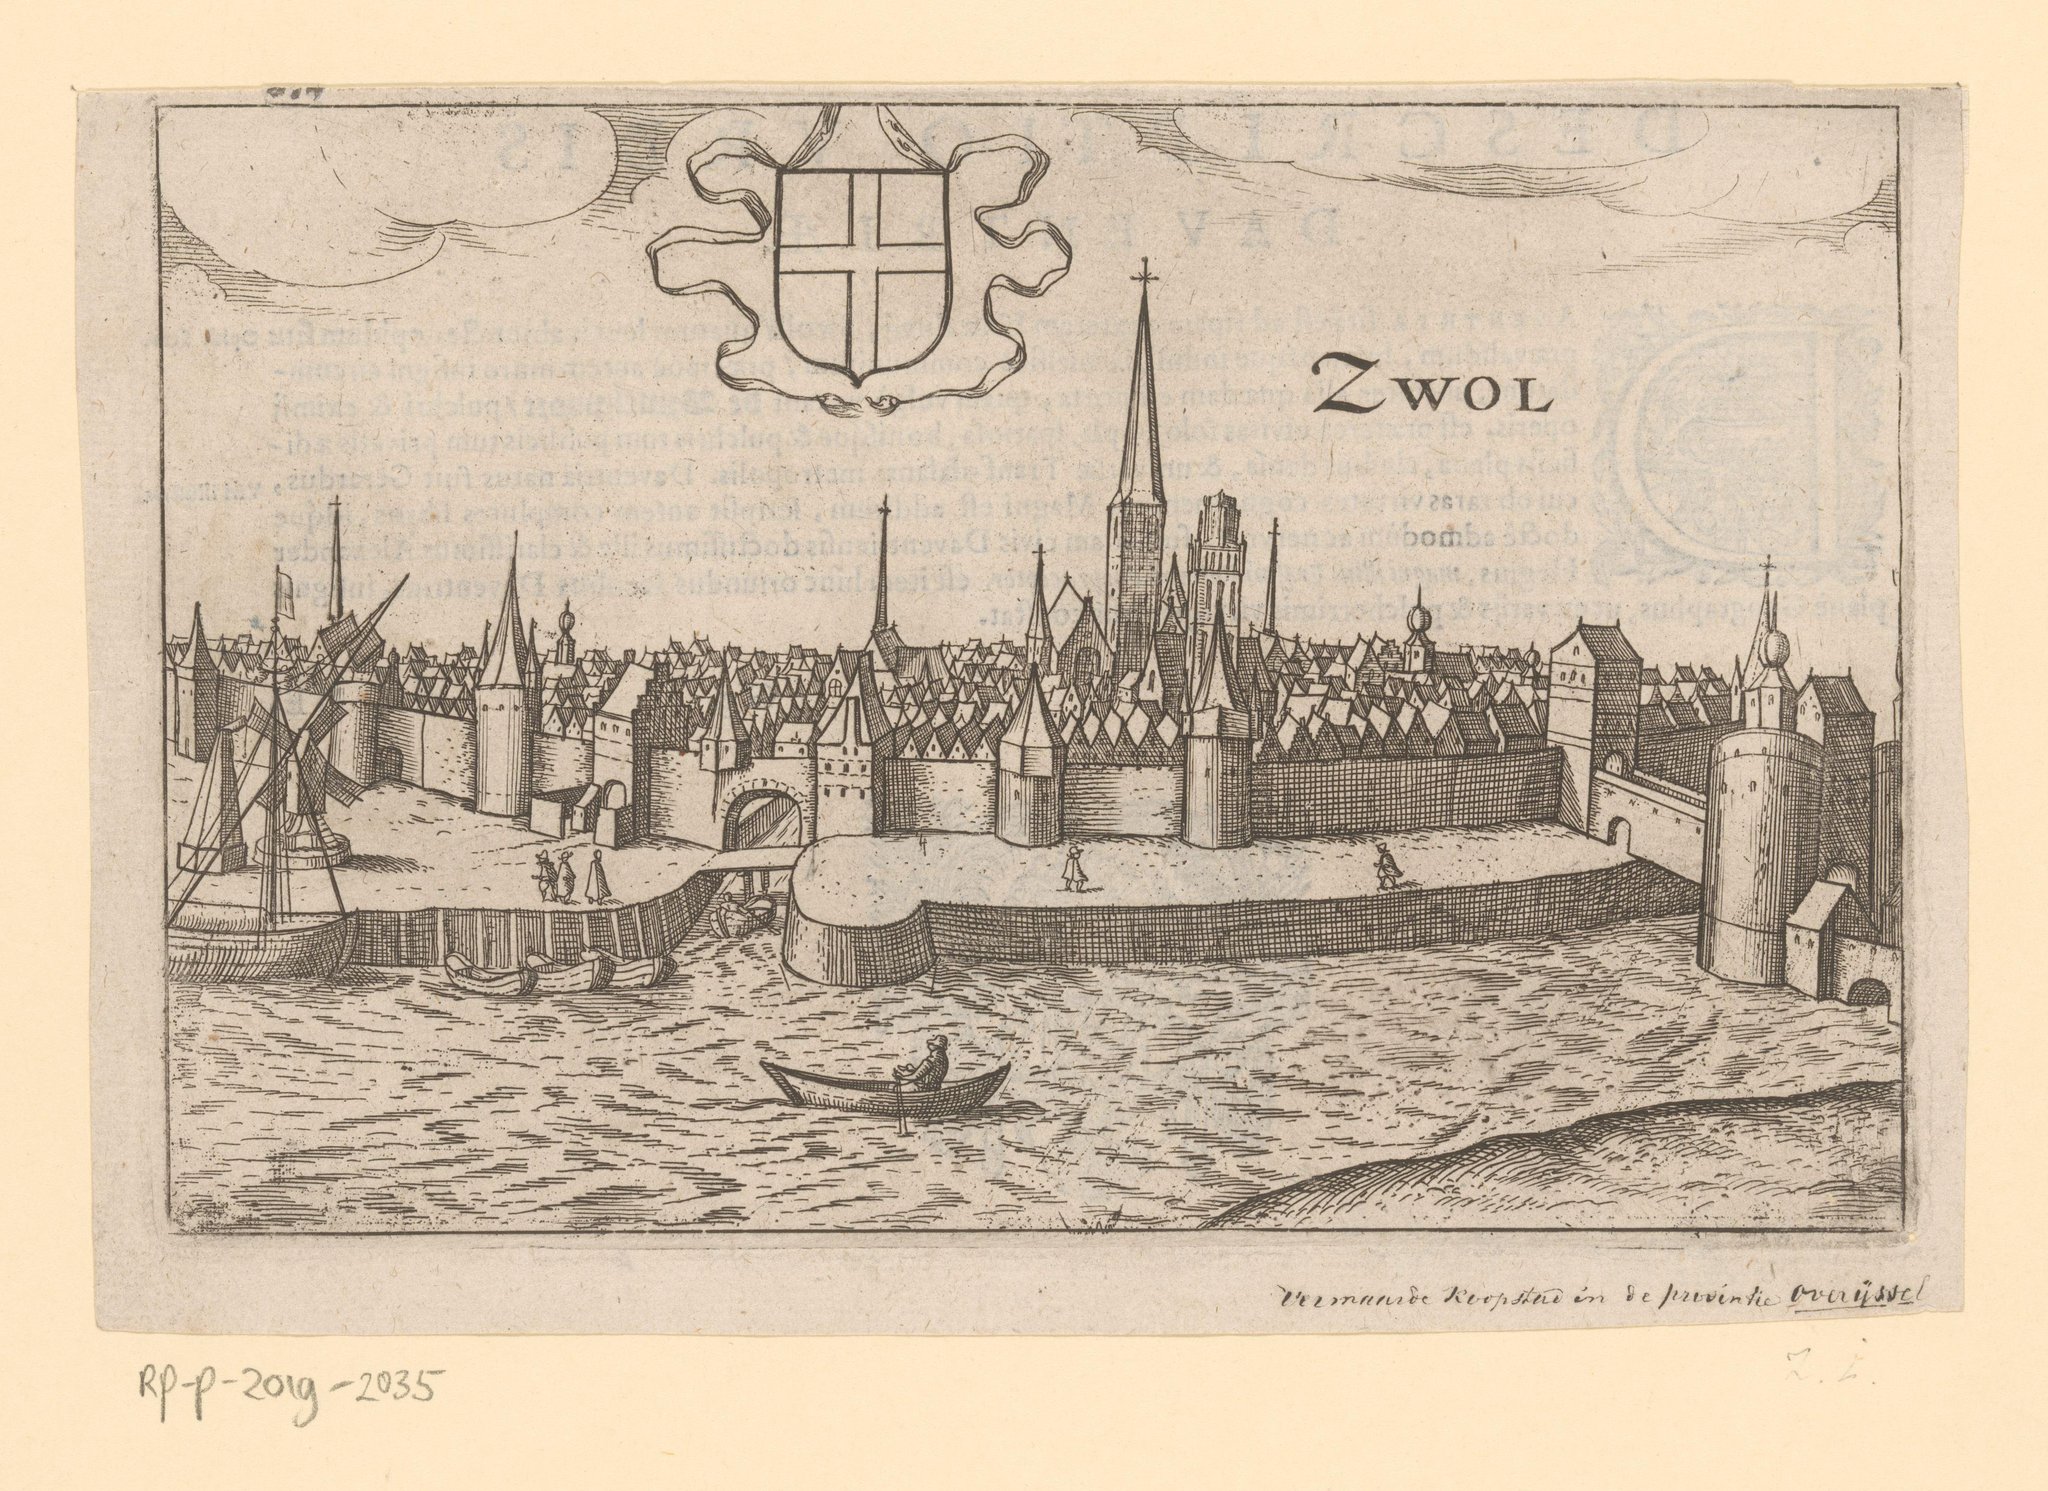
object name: book illustration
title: Zwol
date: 1616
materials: paper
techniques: etching, letterpress printing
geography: arnhem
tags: river, city-view, and landscape with man-made constructions (+ city(-scape) with figures, staffage)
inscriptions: inscription: ‘vermaarde koopstad in de provintie Overijssel’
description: Prent uit: Guicciardini, Lodovico. Omnium Belgii, sive Inferioris Germaniae, Regionum Descriptio (...). Arnhem: Jan Jansz., 1616, p. 233. Prent eerder gebruikt in de Franse uitgave van 1613 bij Jan Jansz.